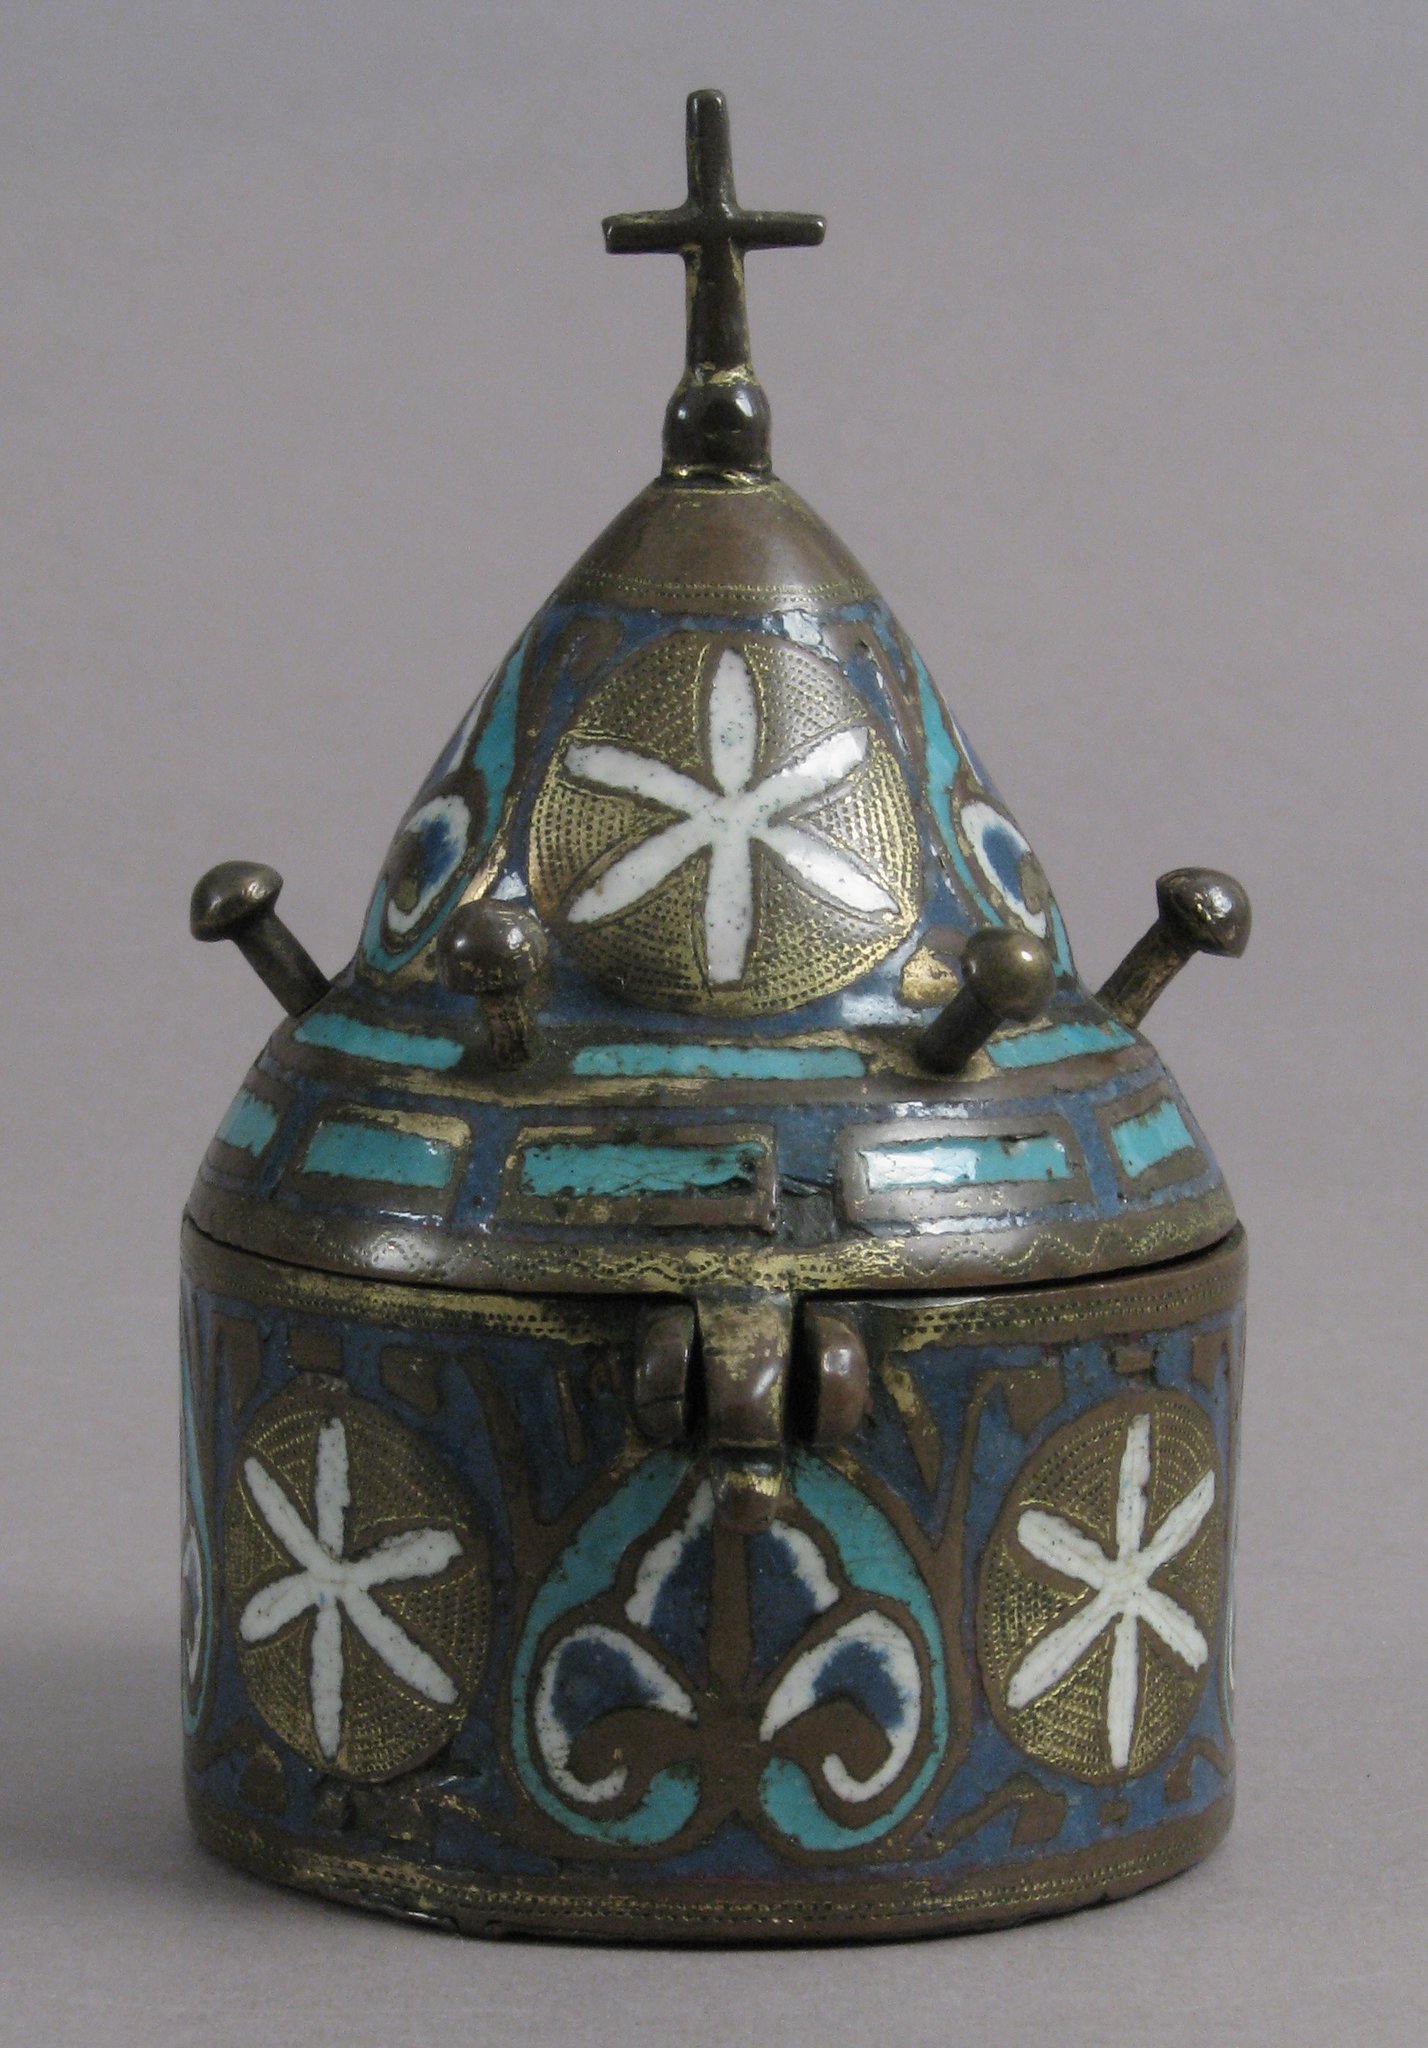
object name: pyx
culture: spanish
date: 1201-1300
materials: gilt copper, enamel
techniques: enamel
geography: spain